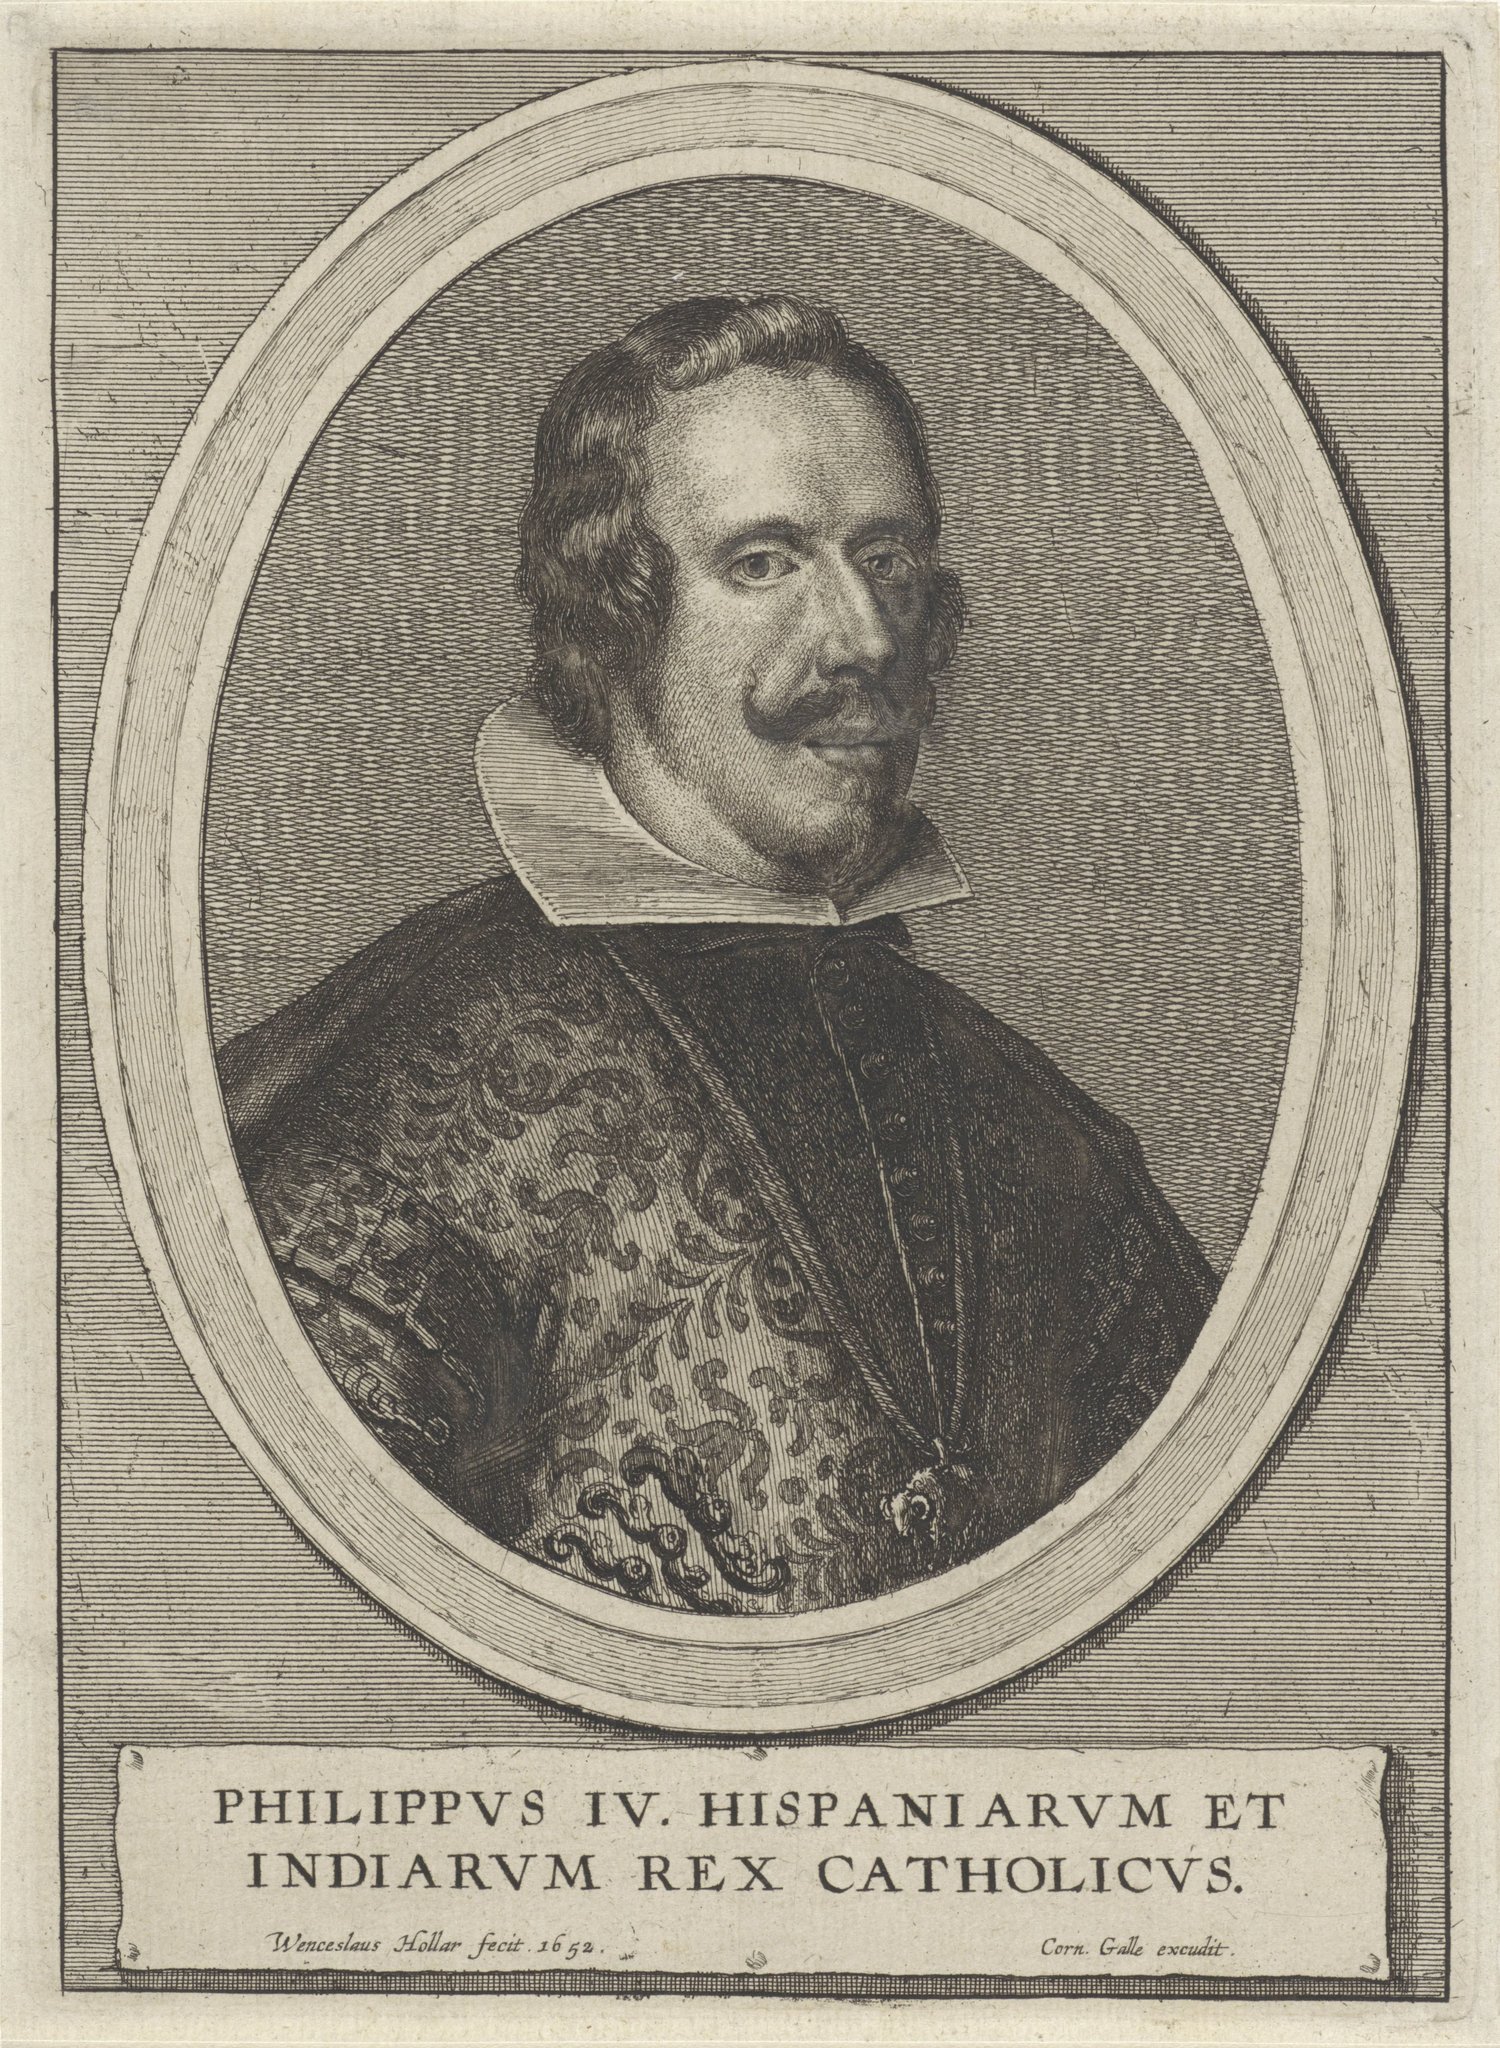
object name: print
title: Portret van Filips IV, koning van Spanje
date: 1652-1678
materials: paper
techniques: etching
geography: antwerp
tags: filips iv (koning van spanje)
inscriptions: collector's mark: Lugt 2228